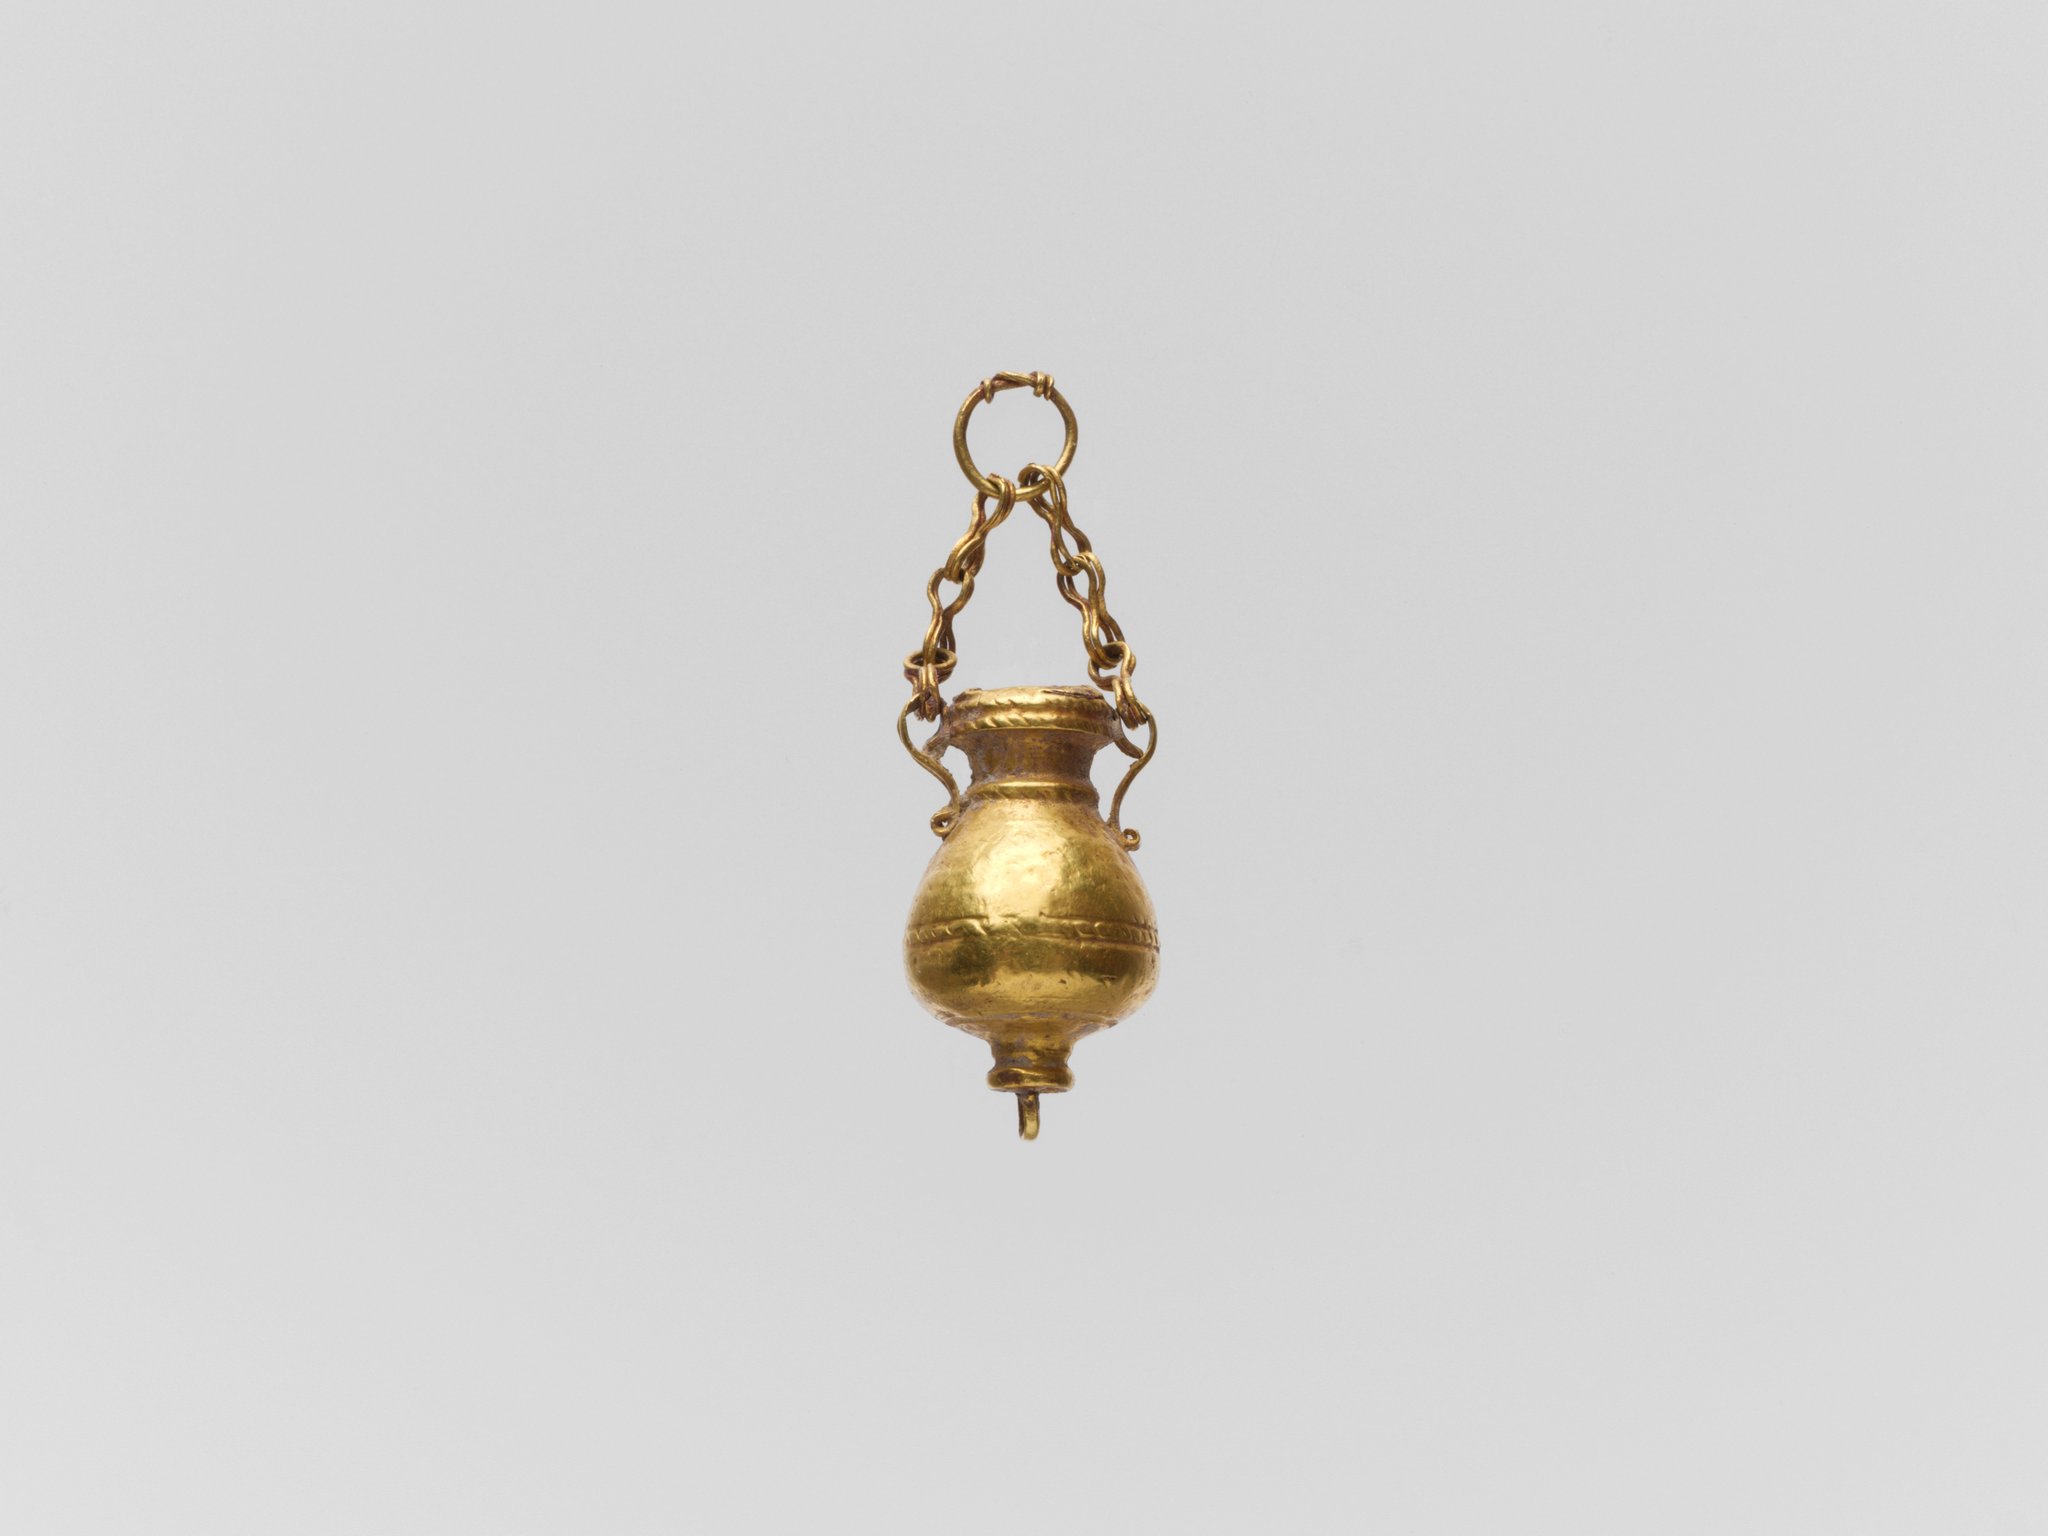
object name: pendant in the form of a perfume bottle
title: Gold pendant in the form of a vase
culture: greek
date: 200-101 BCE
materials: gold